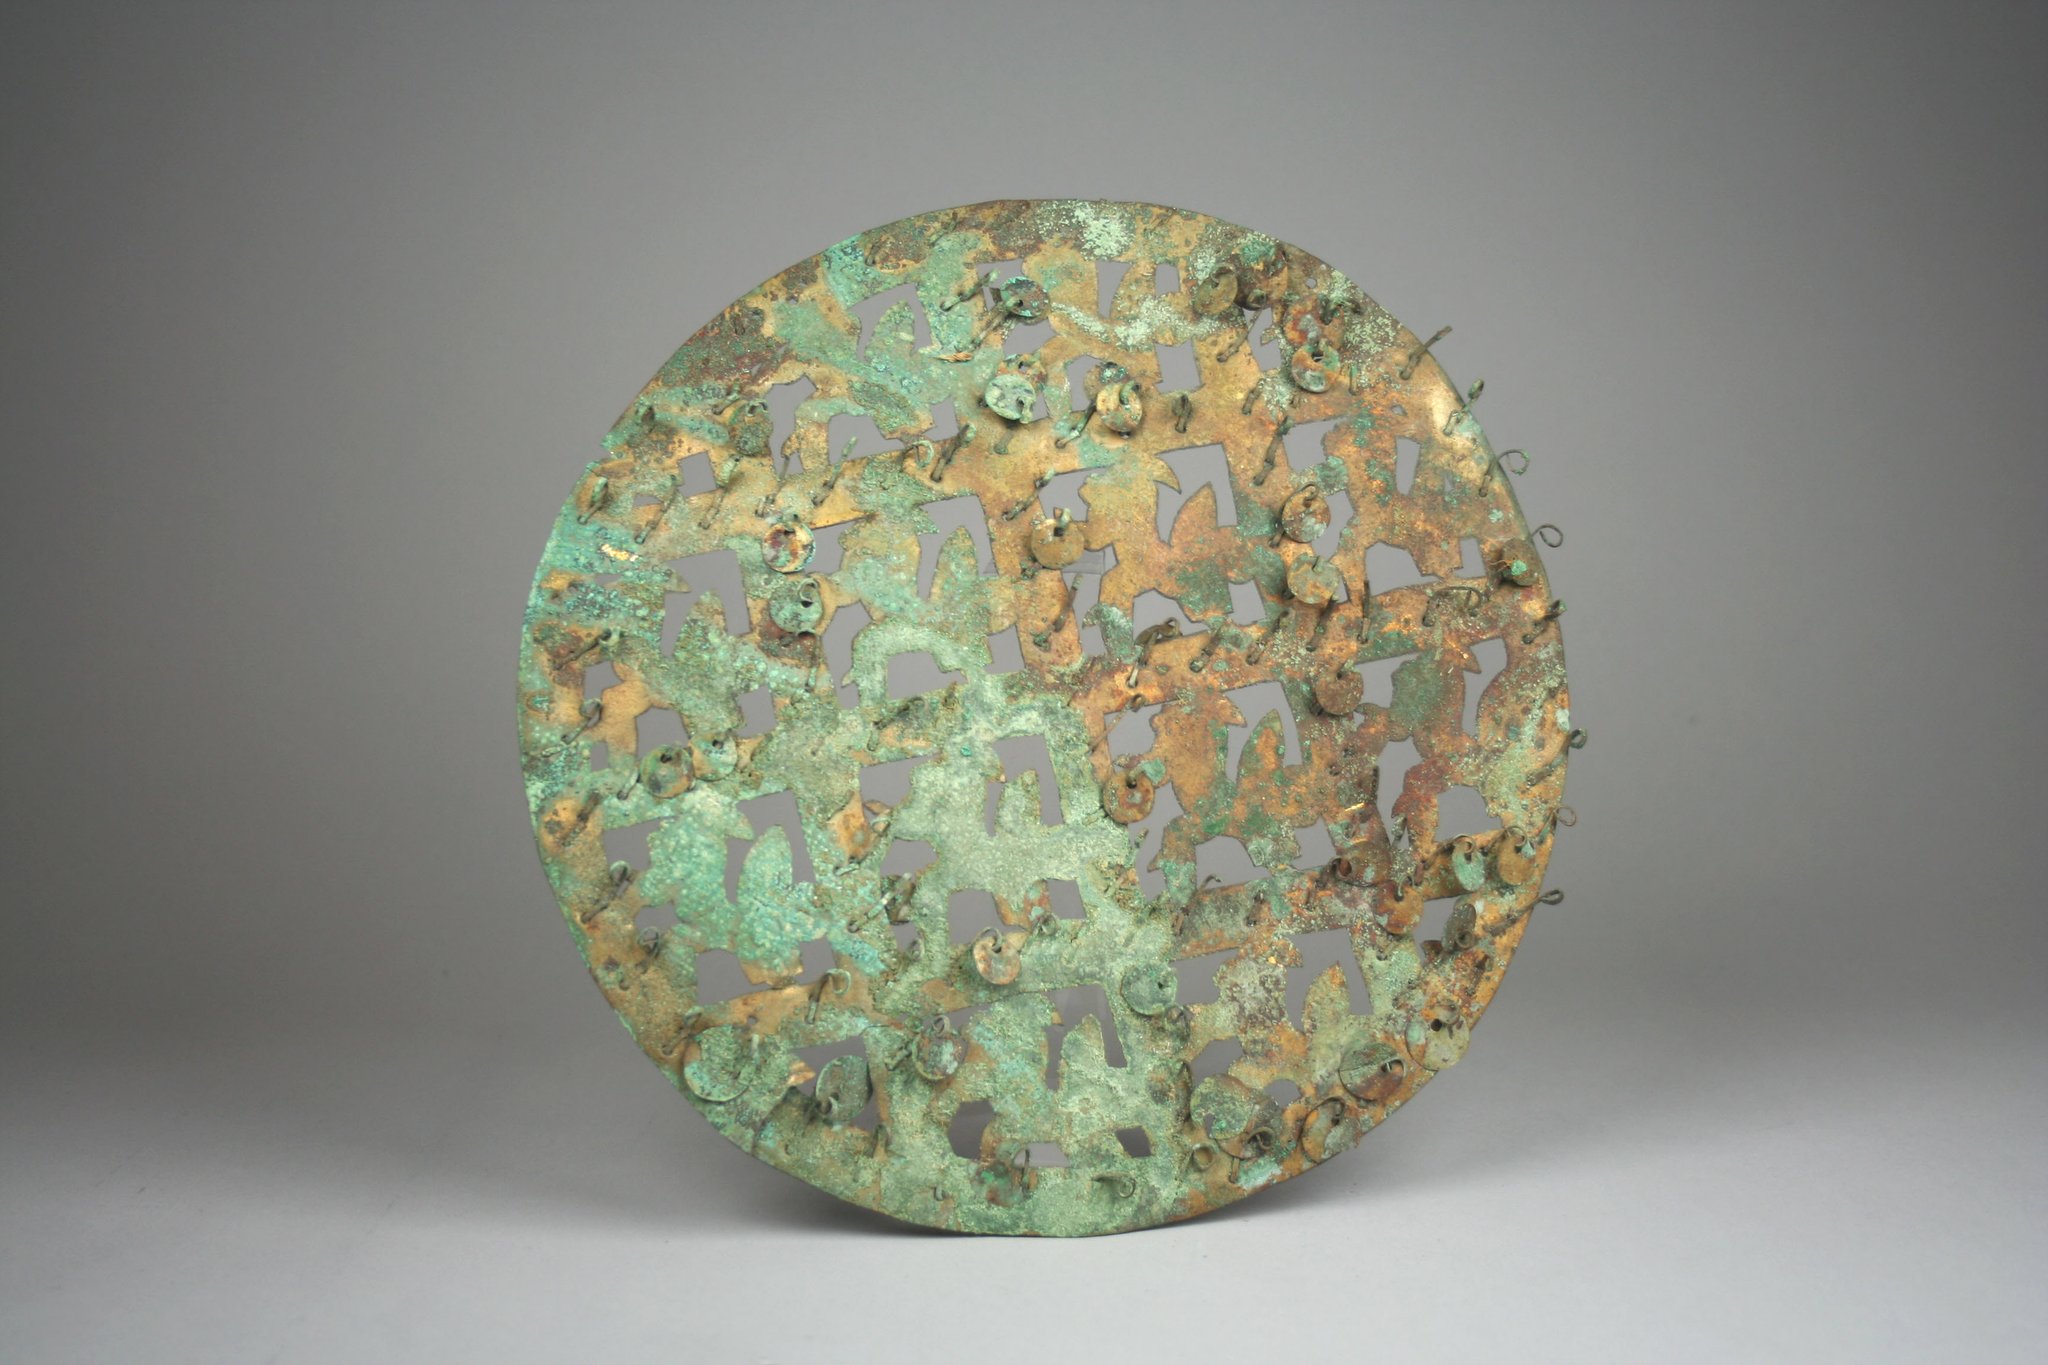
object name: ornament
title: Cutout Disk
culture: moche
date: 501-700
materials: gilt copper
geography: peru